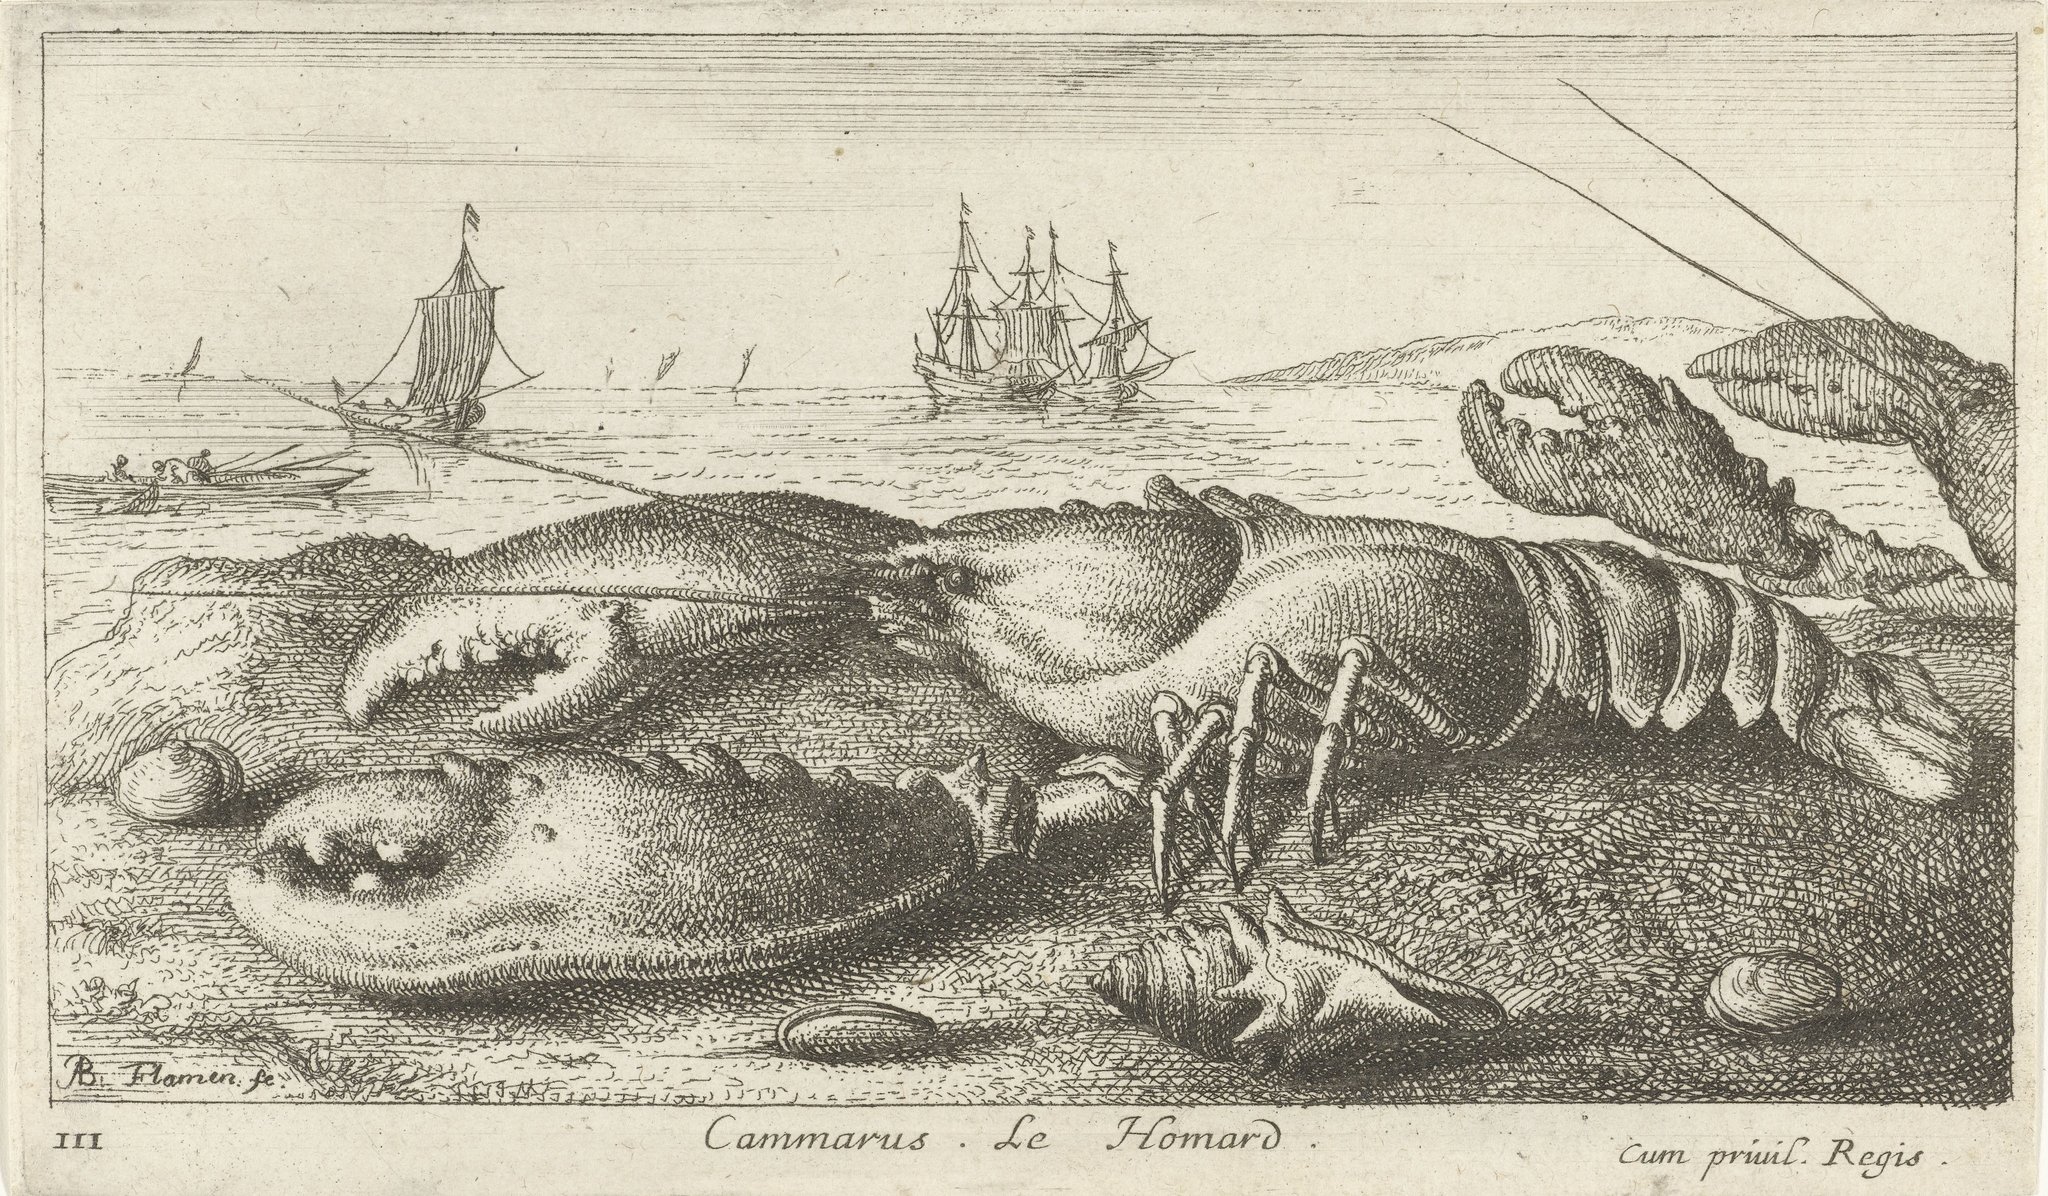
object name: print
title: Cammarus. Le Homard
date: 1664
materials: paper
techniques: etching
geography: paris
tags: crustaceans: lobster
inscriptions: collector's mark: Lugt 240